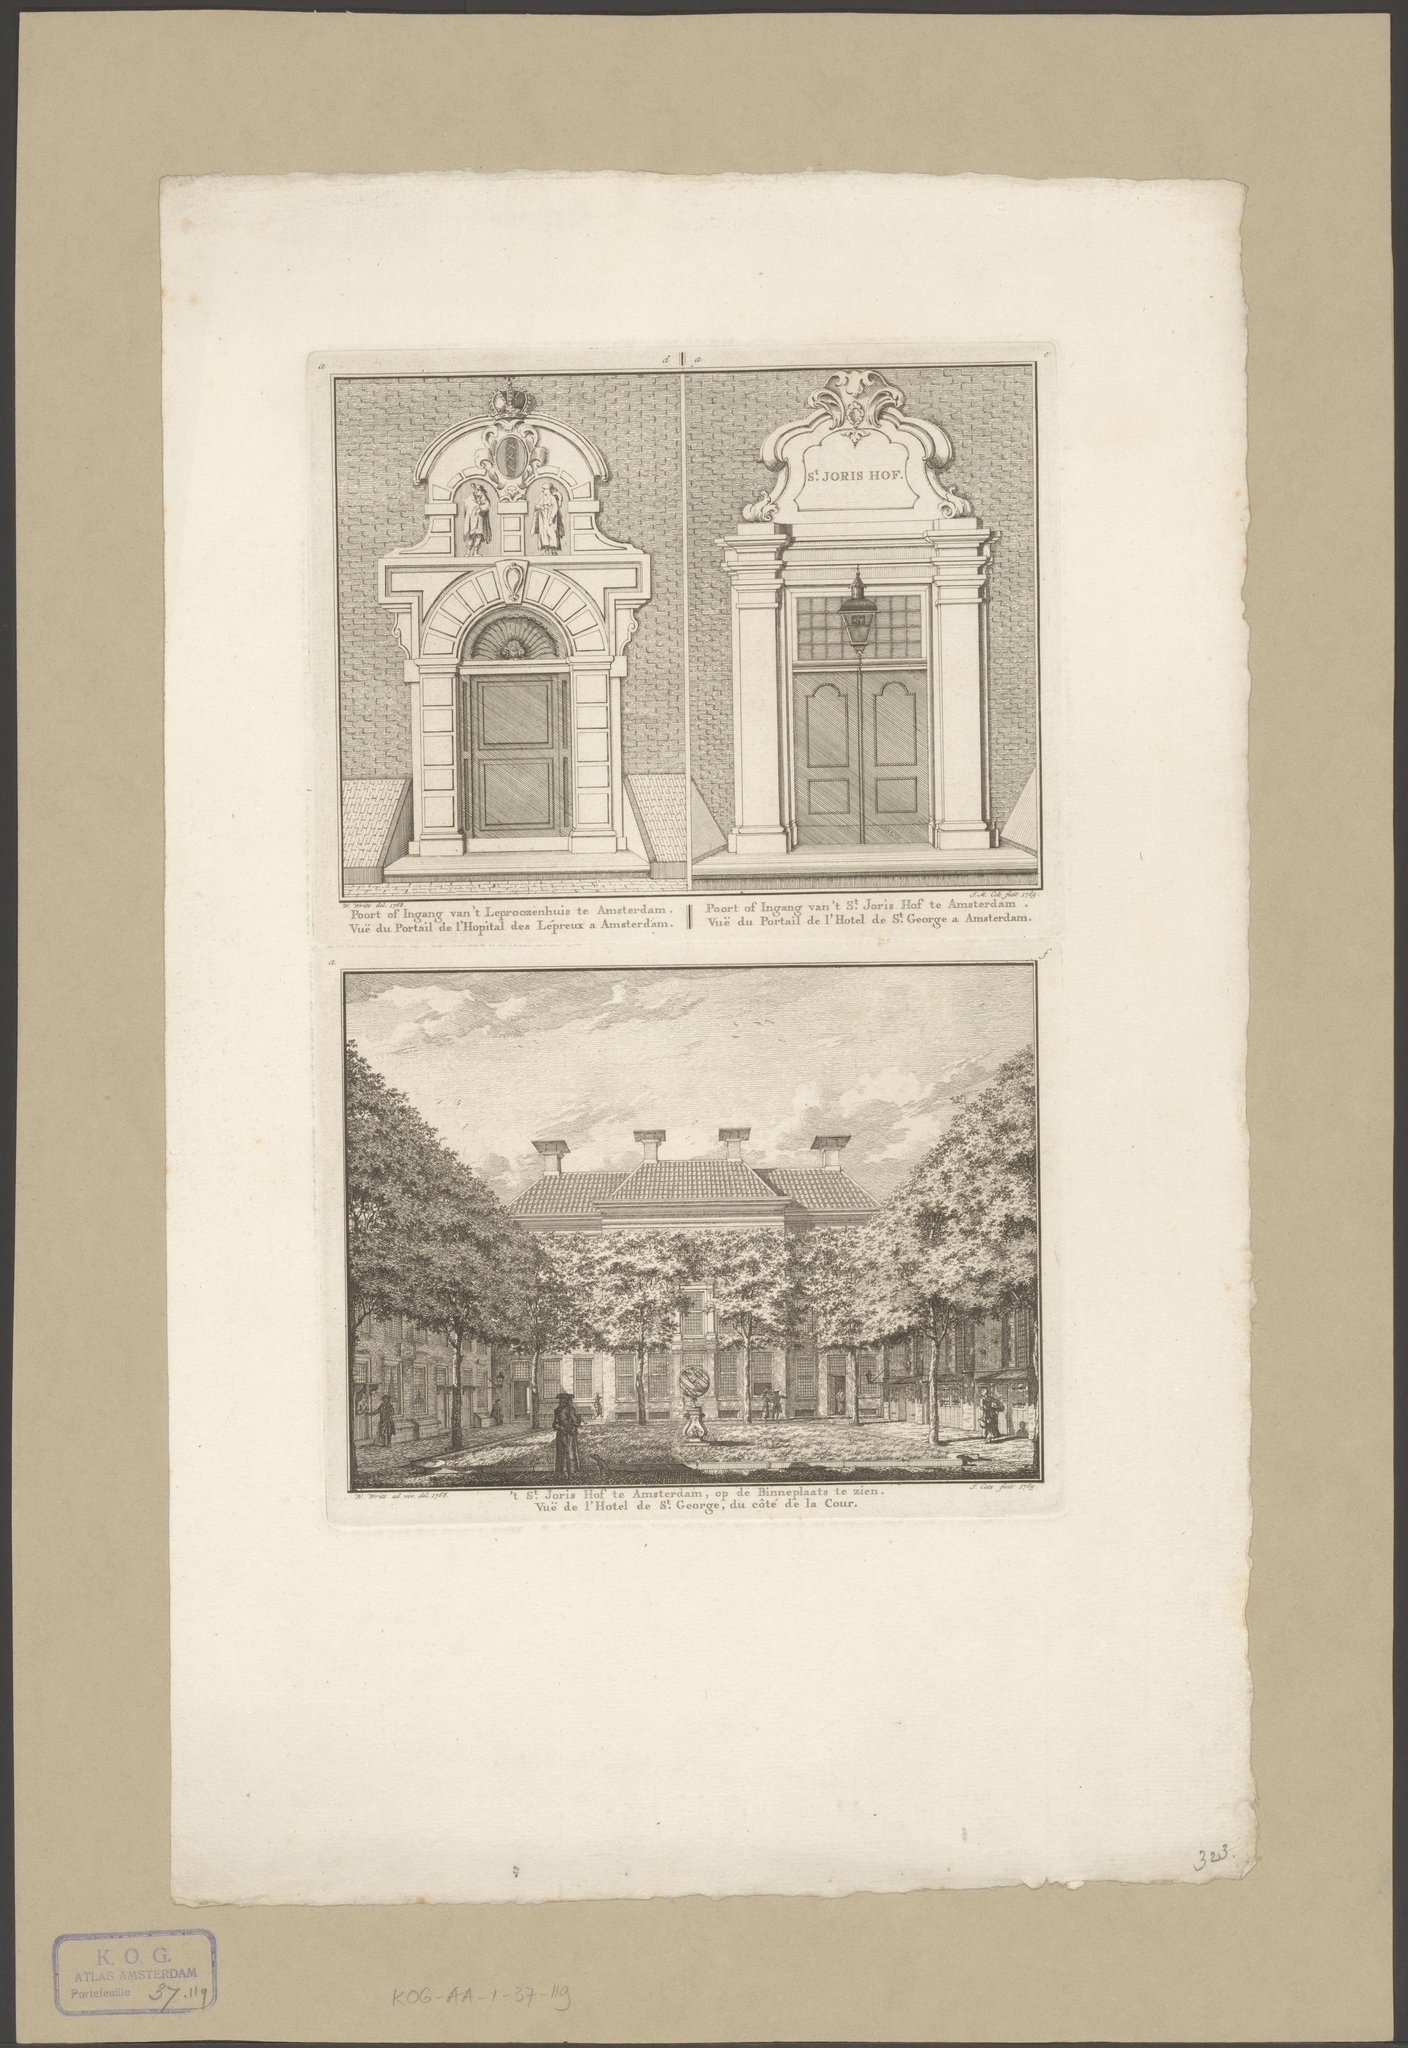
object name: print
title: Poort of Ingang van 't St. Joris Hof te Amsterdam / Vuë du Portail de l'Hotel de St. George a Amsterdam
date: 1769-1804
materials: paper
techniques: engraving, etching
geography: amsterdam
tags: alms-house (dutch: 'hofje'), leprosarium, gate, entrance, courtyard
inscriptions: collector's mark: Lugt 1641b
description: Prent mogelijk uit: Atlas van de stad Amsterdam (...) / Atlas de la ville d'Amsterdam (...). Amsterdam: Reinier (II) Ottens, Pieter Yver, Johannes Smit, Frederik Willem Greebe, Albert van der Kroe en Jan Christiaan Sepp, 1769, dl. 3. Of uit: Elwe, Jan Barend. Atlas van de wereldberoemde koopstad Amsteldam (...). Amsterdam: Jan Barend Elwe, 1804.